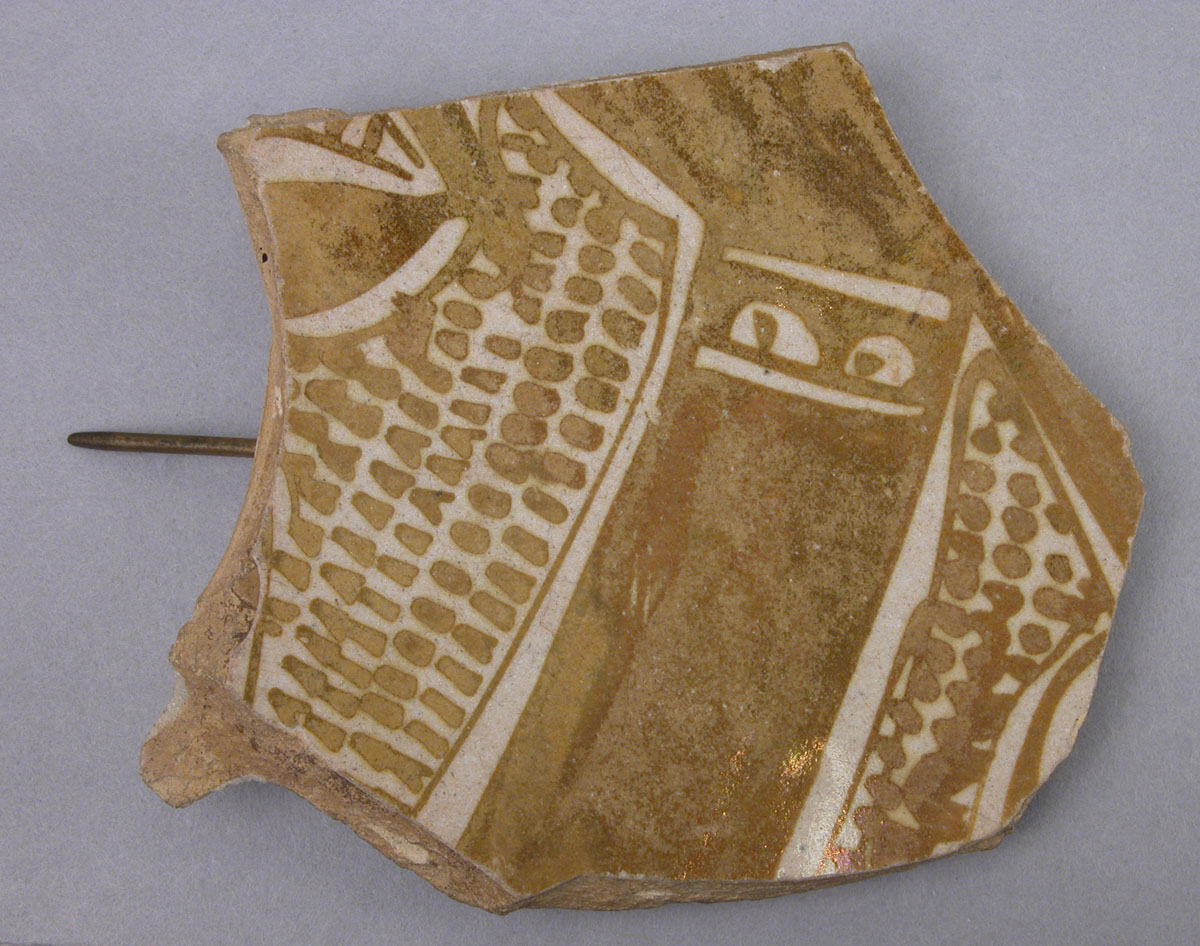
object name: fragment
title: Ceramic Fragment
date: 801-900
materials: glaze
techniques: luster painting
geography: iraq